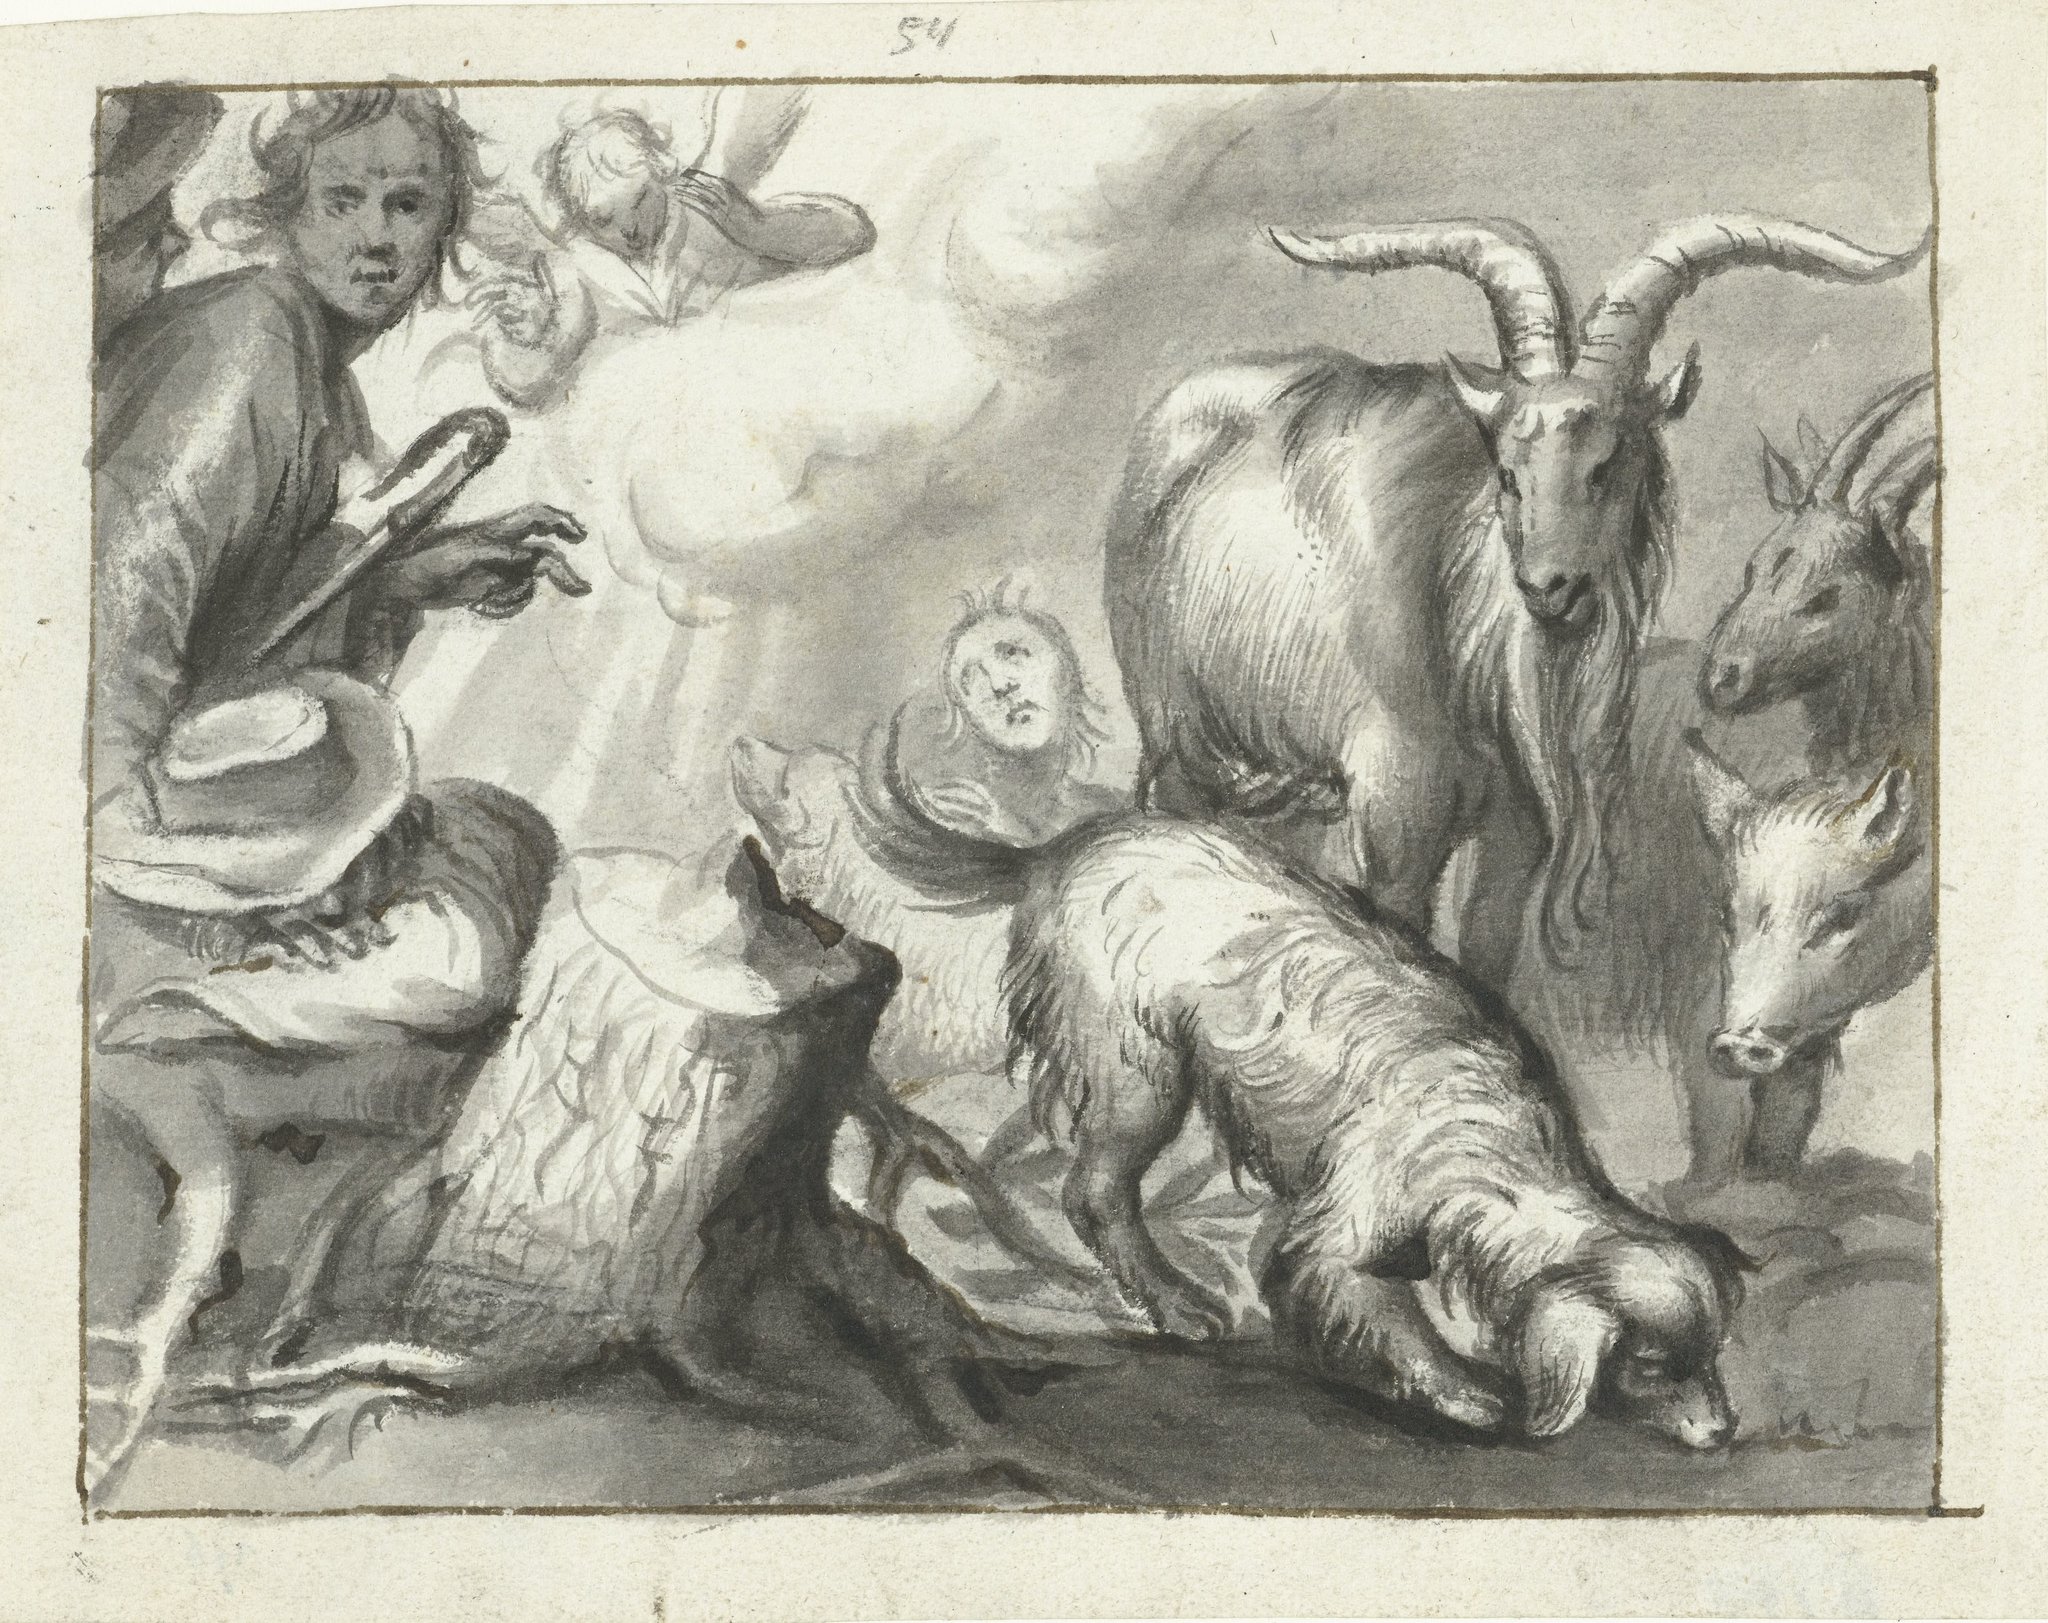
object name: drawing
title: Verkondiging aan de herders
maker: moses ter borch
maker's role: draughtsman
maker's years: 1645-1667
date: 1660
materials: chalk, ink, paper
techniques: brush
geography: zwolle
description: De bron voor deze tekening was Abraham Bloemaerts 'Verkondiging aan de herders', no. 7 in de serie van veertien pastoralen geëtst door Bolswert.